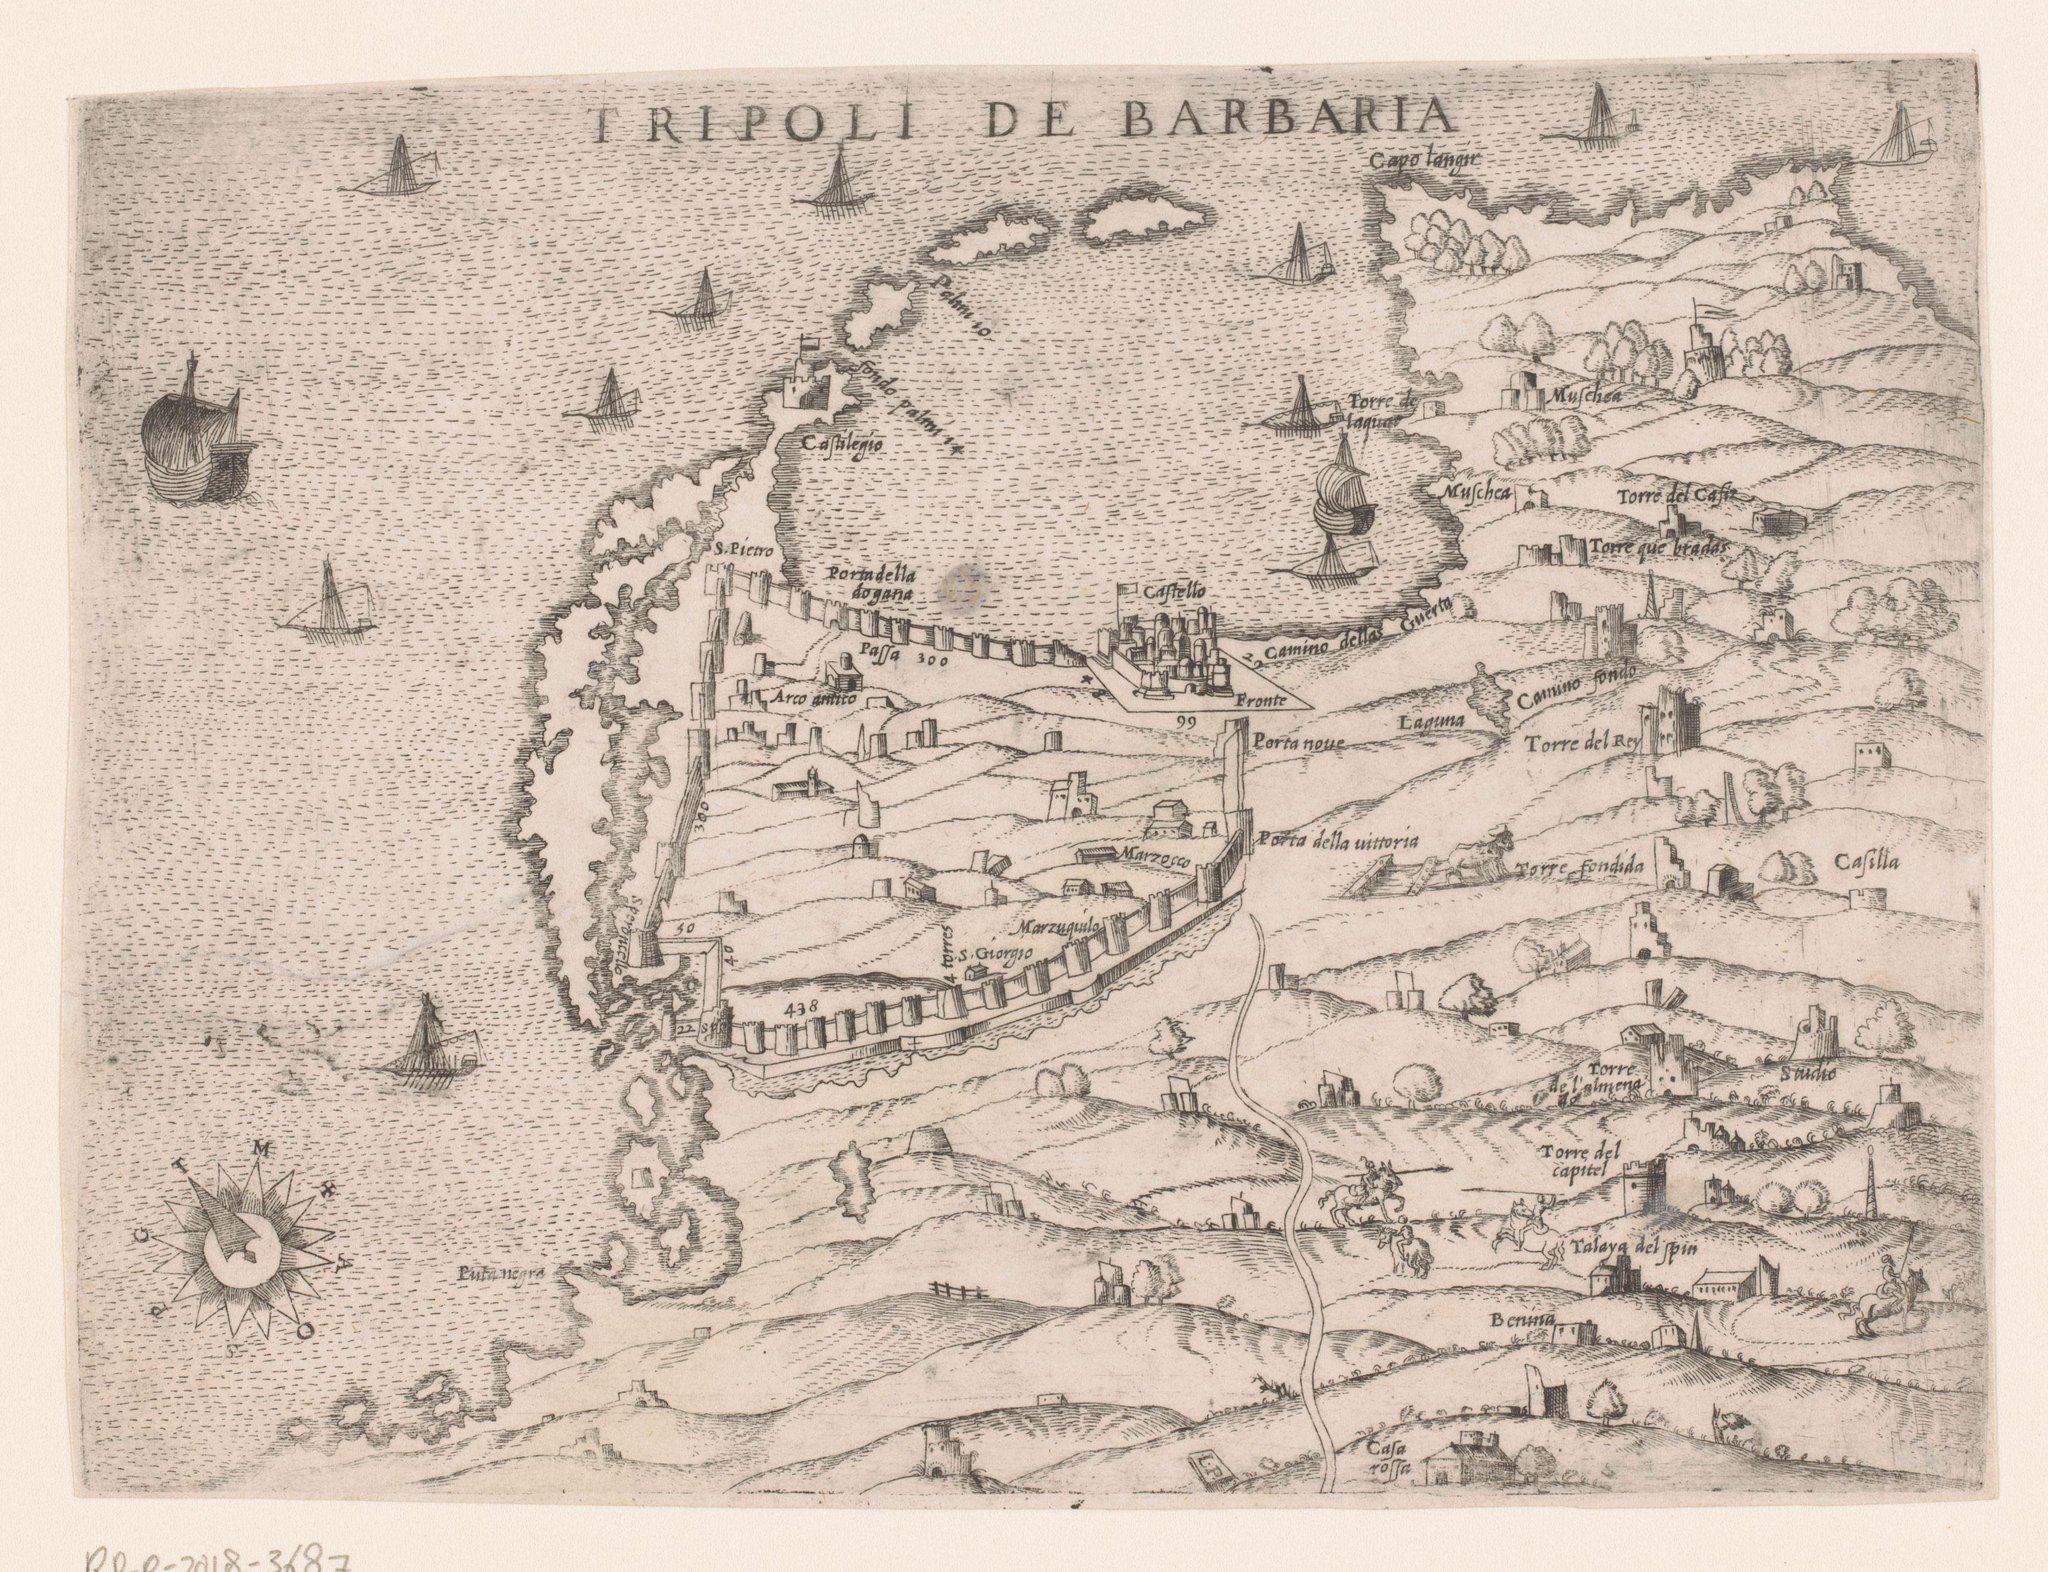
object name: print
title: Gezicht op Tripoli in Libië in vogelvluchtperspectief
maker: Anonymous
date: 1567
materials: paper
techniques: etching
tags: maps, atlases, fortified city, maps of cities